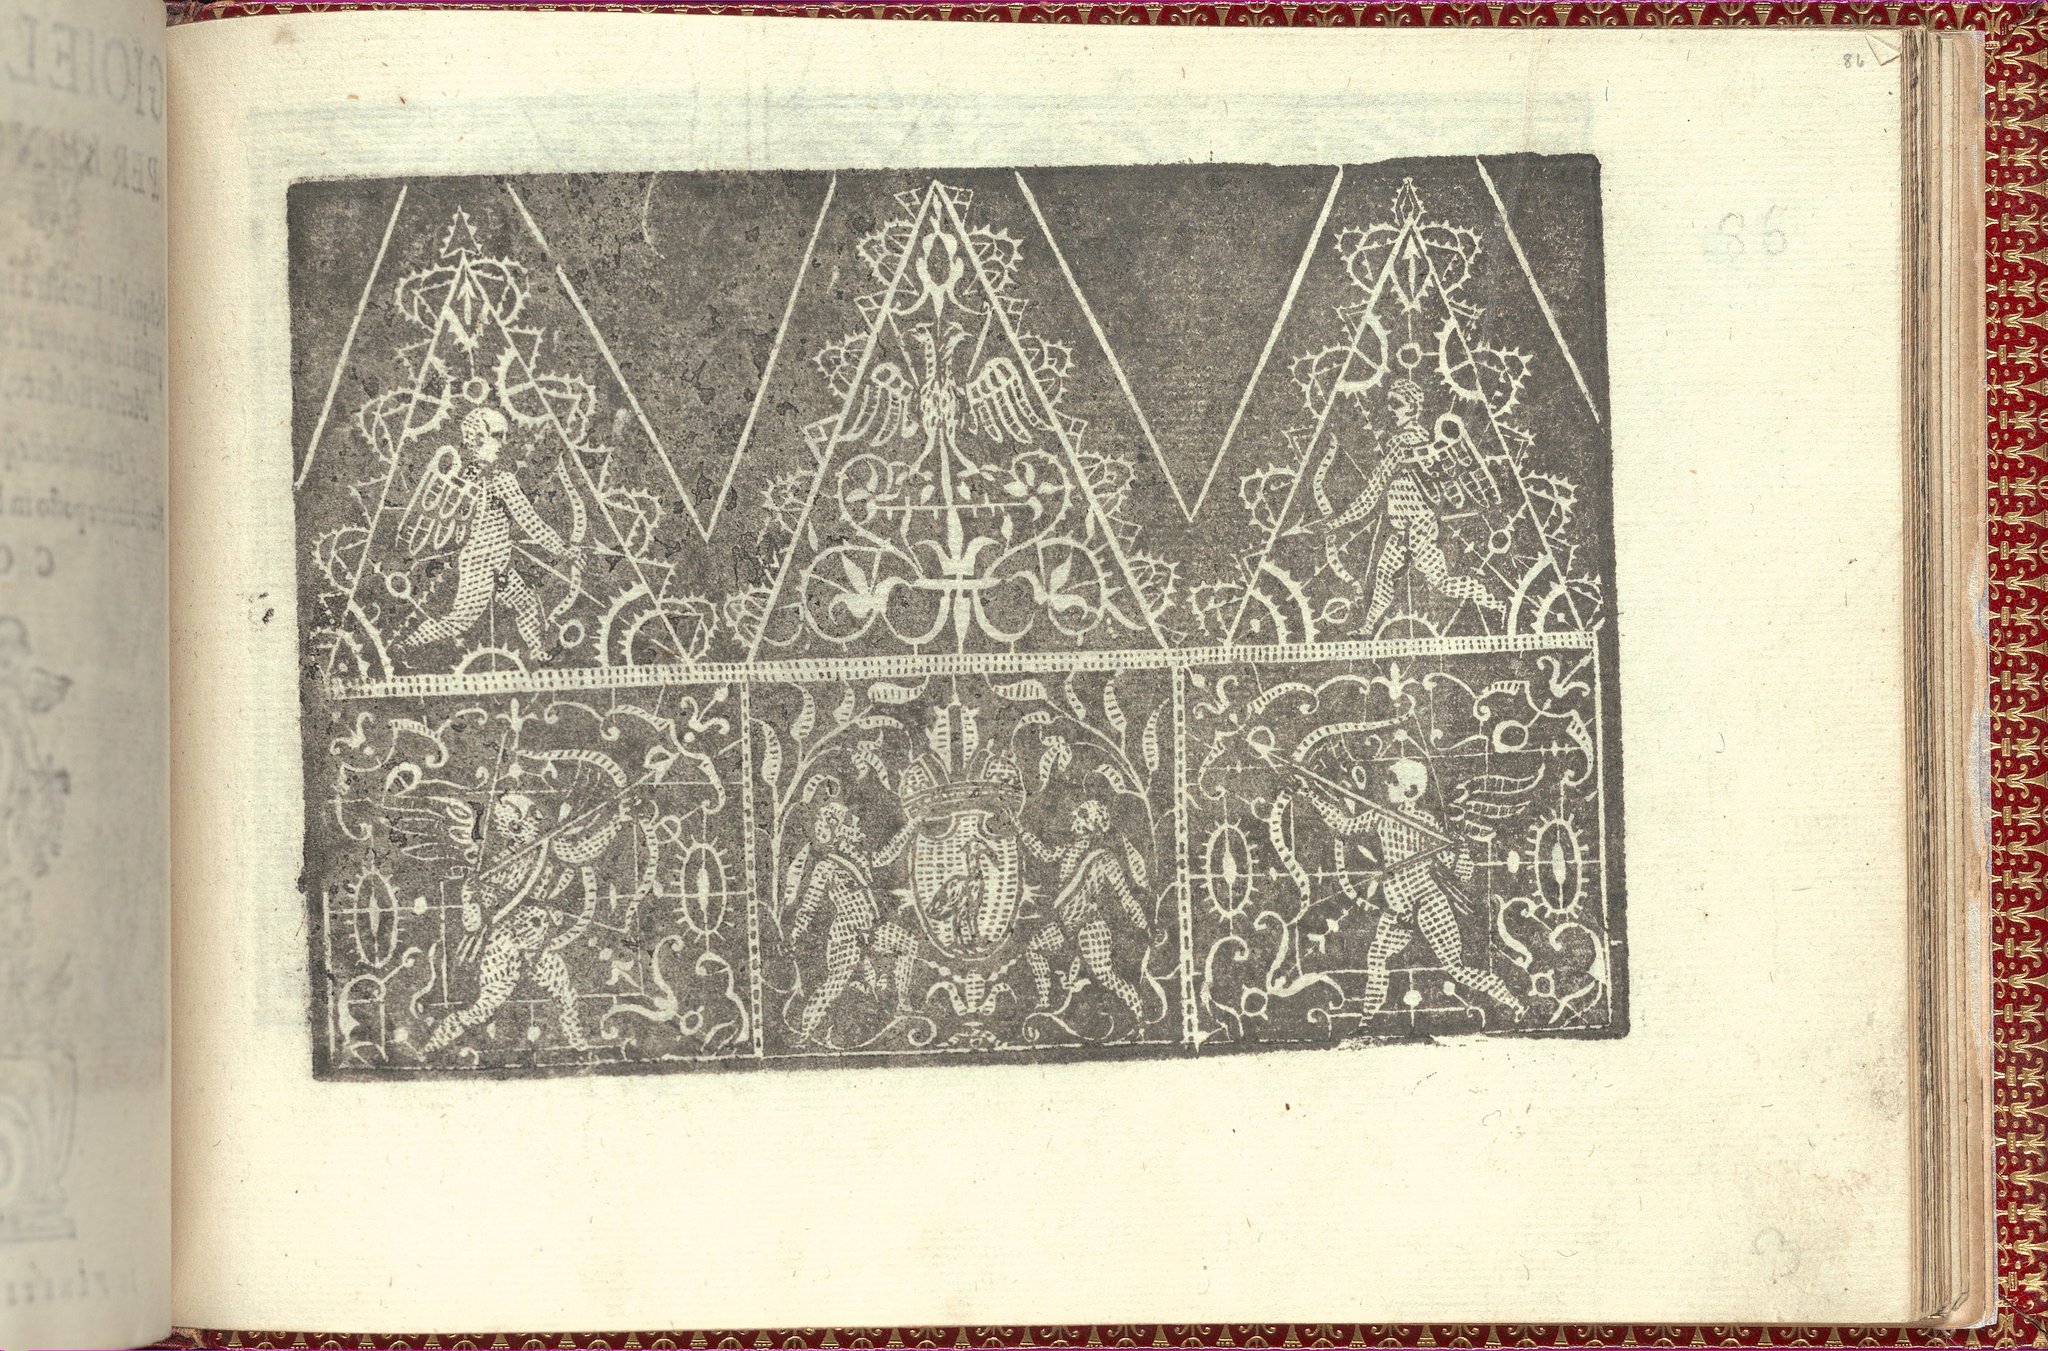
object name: book print ornament architecture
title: Corona delle Nobili et Virtuose Donne: Libro I-IV, page 86 (recto)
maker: cesare vecellio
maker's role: publisher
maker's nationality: italian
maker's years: 1521-1601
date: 1601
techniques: woodcut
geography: italy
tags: coat of arms